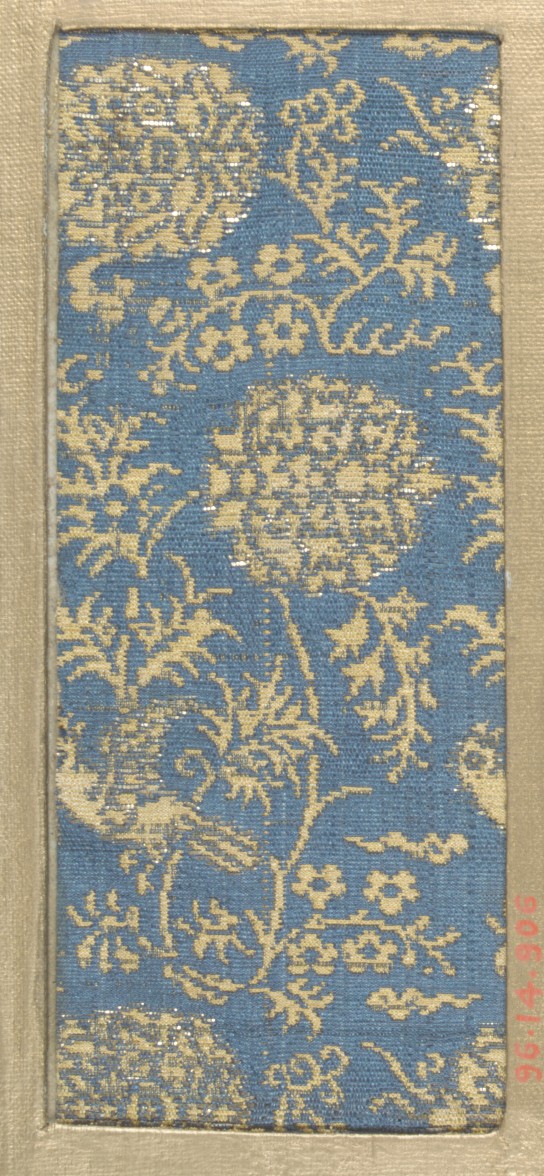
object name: piece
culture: japanese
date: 1701-1900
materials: silk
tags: birds